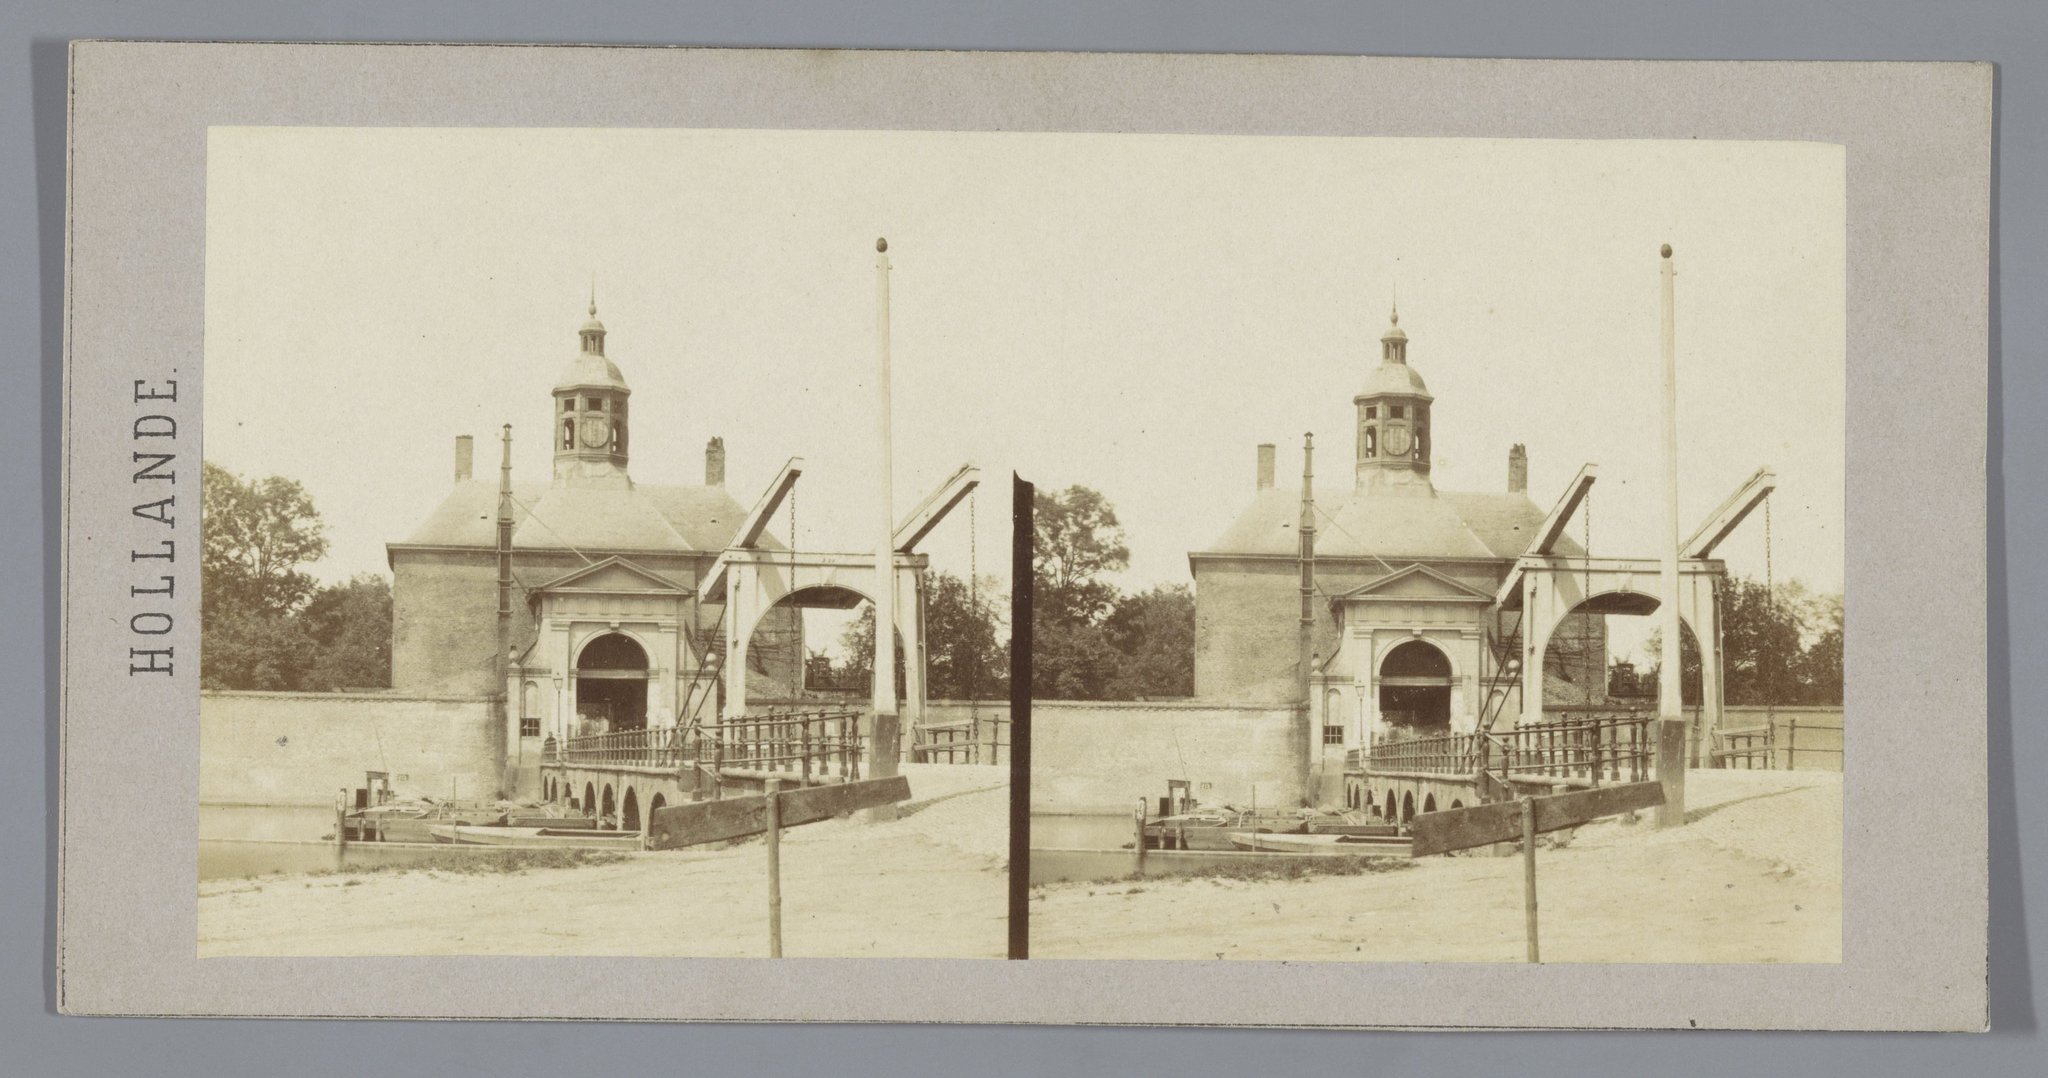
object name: stereograph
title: Une porte a Amsterdam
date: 1858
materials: cardboard, paper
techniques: albumen print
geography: amsterdam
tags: bridge, city-gate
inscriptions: inscription: ‘Utrechtsepoort./ Afgebroken 1859’, number: ‘N. 18.’